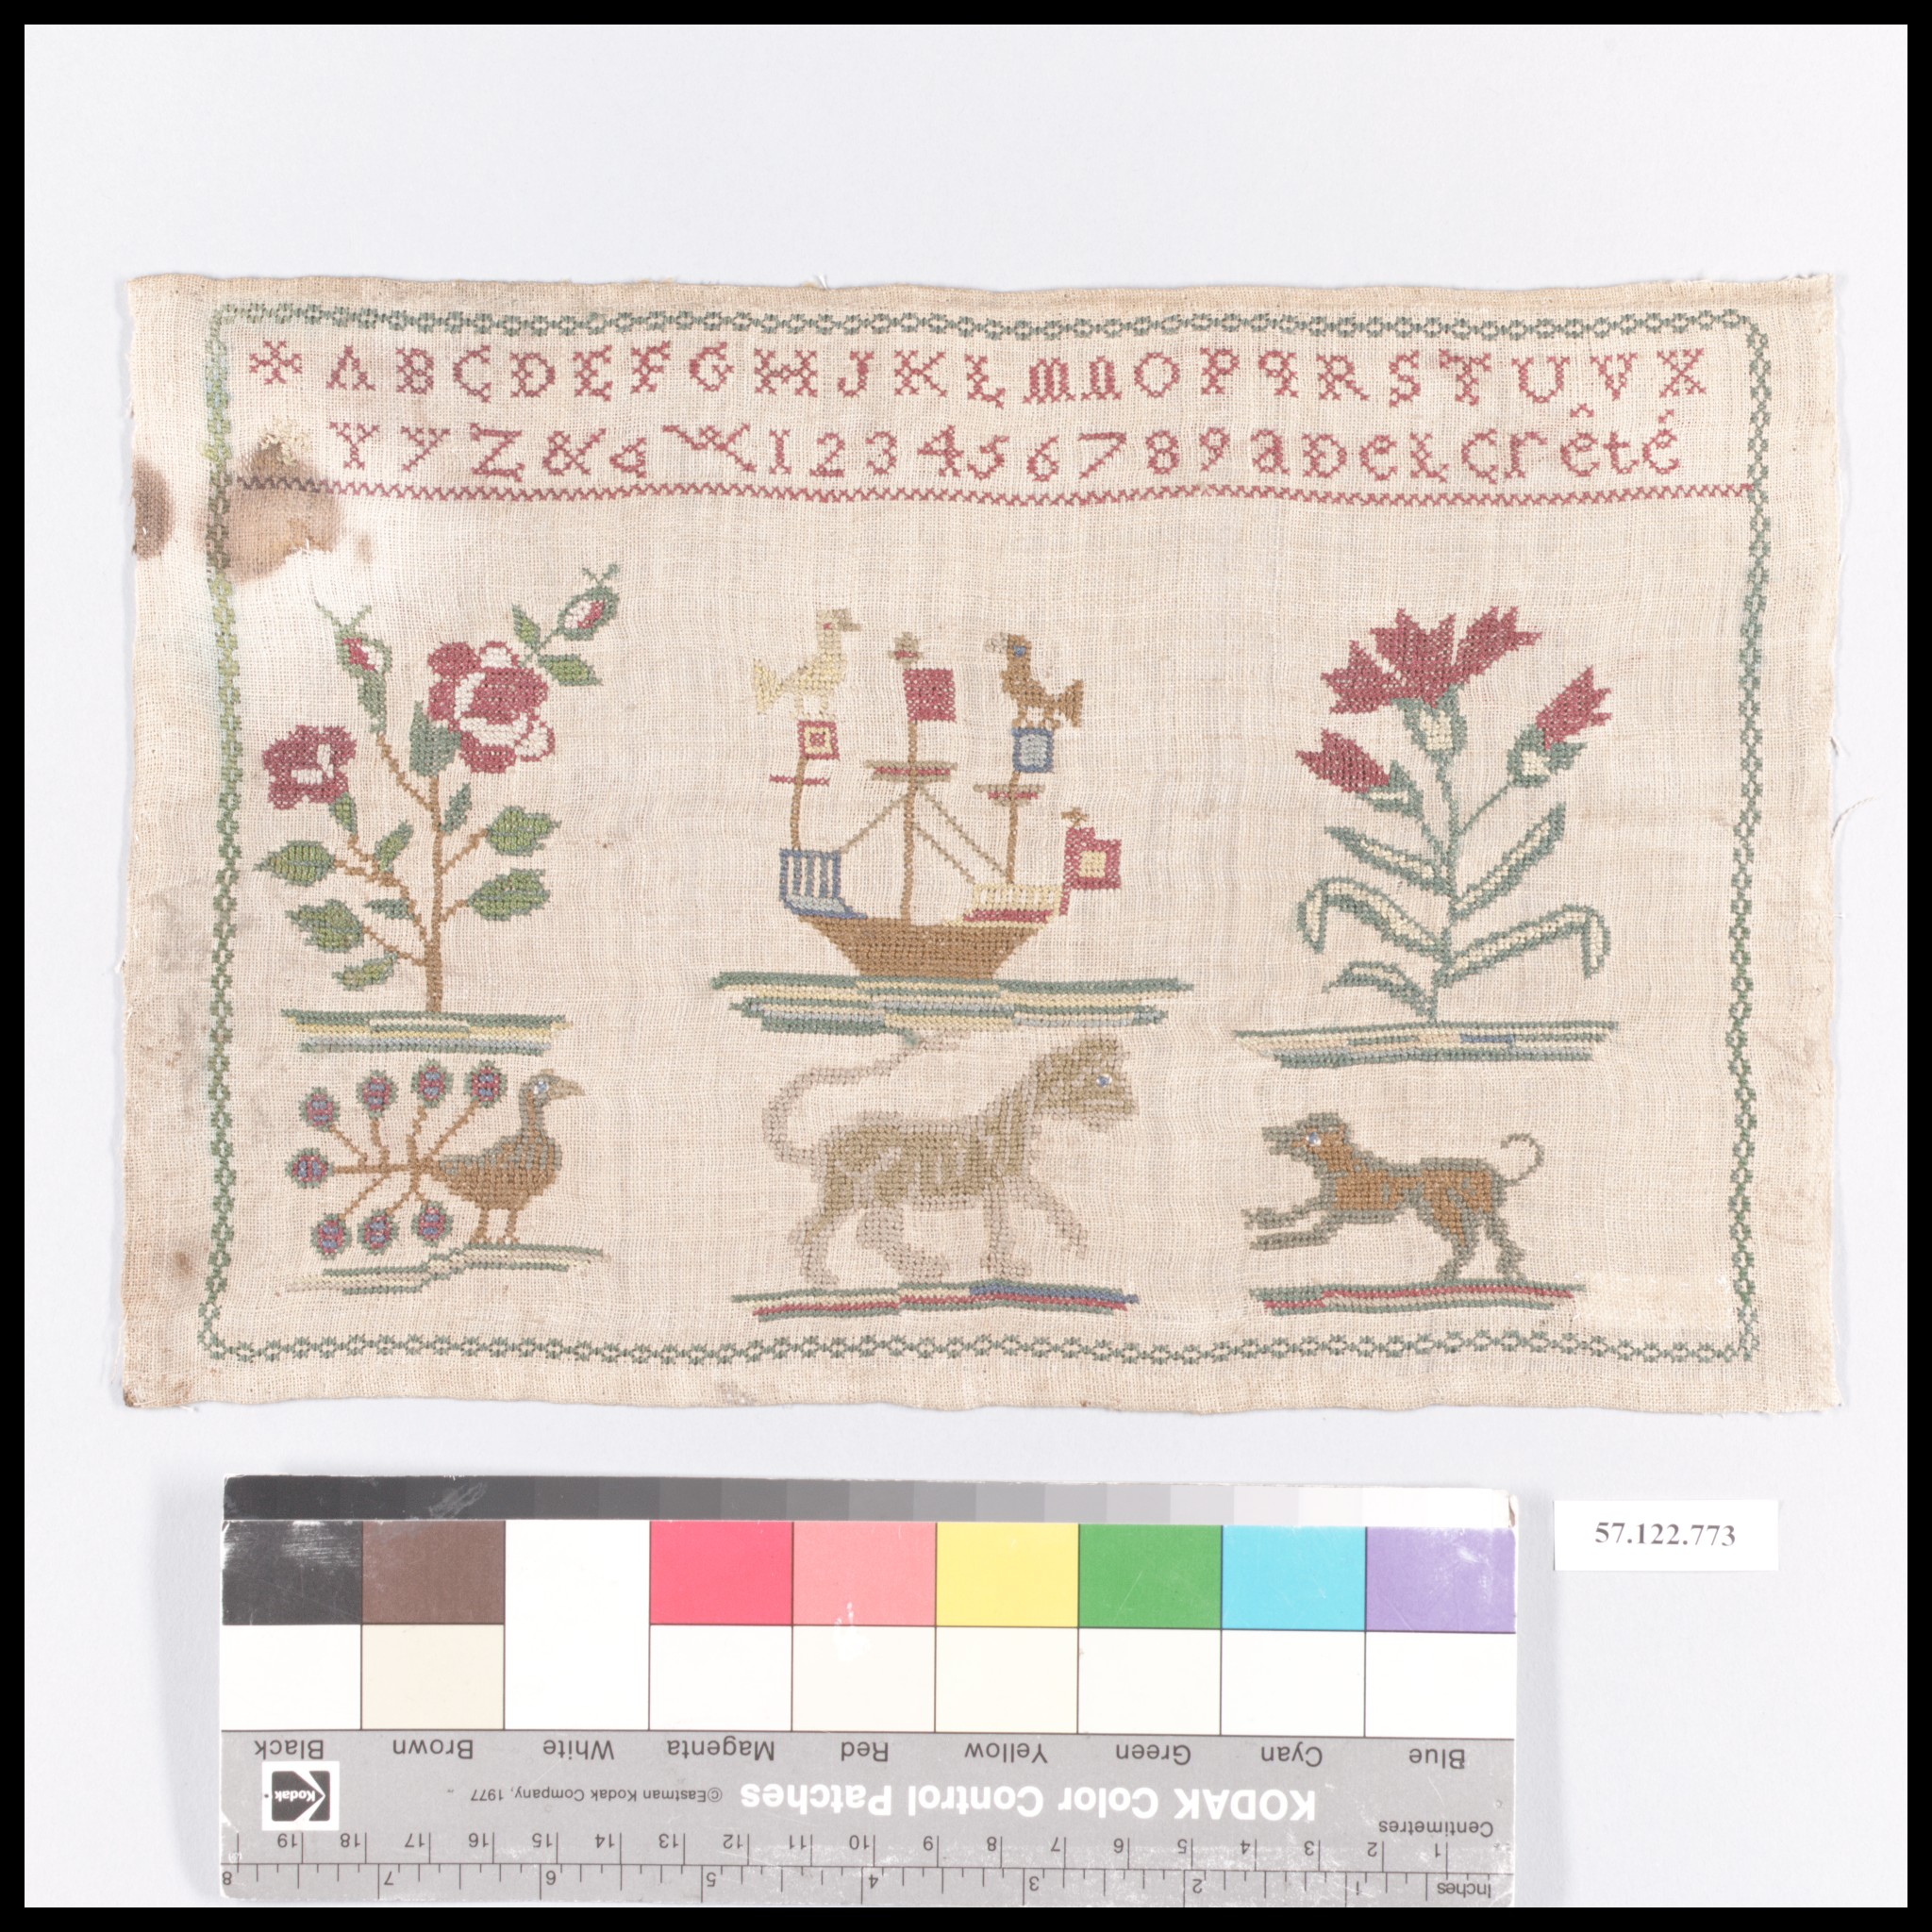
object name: sampler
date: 1801-1900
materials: linen, silk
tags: animals,birds,flowers